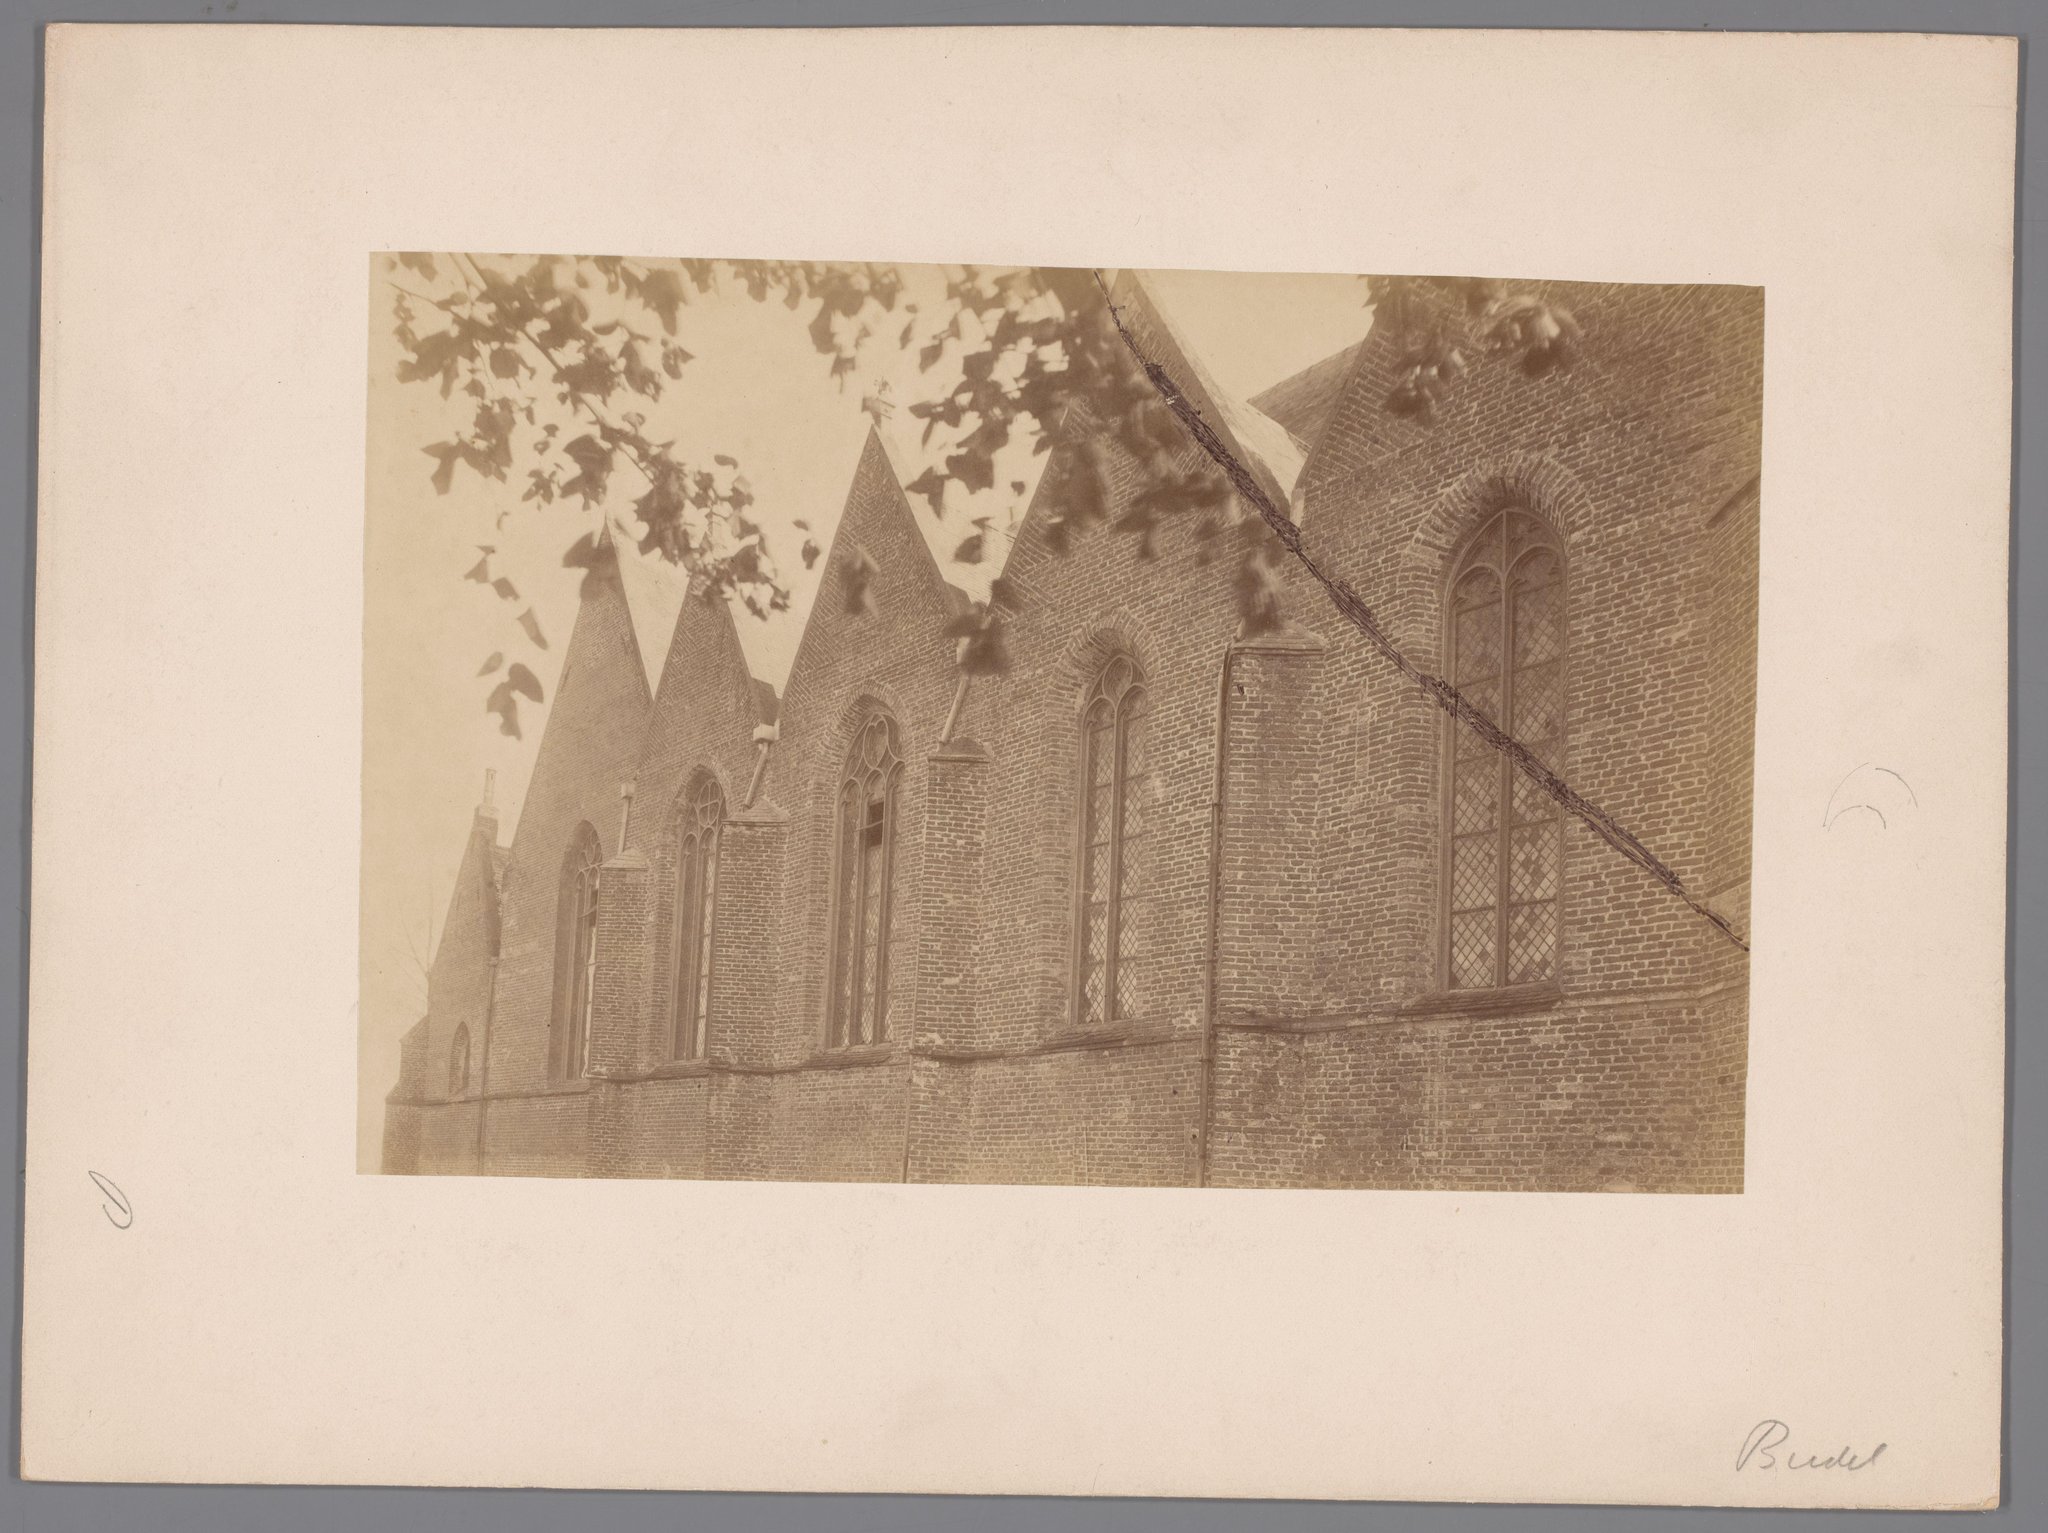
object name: photograph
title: Noordzijde van de Oude Onze-Lieve-Vrouw Visitatiekerk te Budel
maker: anoniem (monumentenzorg)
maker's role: fotograaf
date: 1902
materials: cardboard, photographic support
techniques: albumen print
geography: budel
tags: church (exterior)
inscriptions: annotation: ‘Budel R.K. Kerk (N.B.)/ Noordelijk: gevel/ Mei 1902’, annotation: ‘Budel’